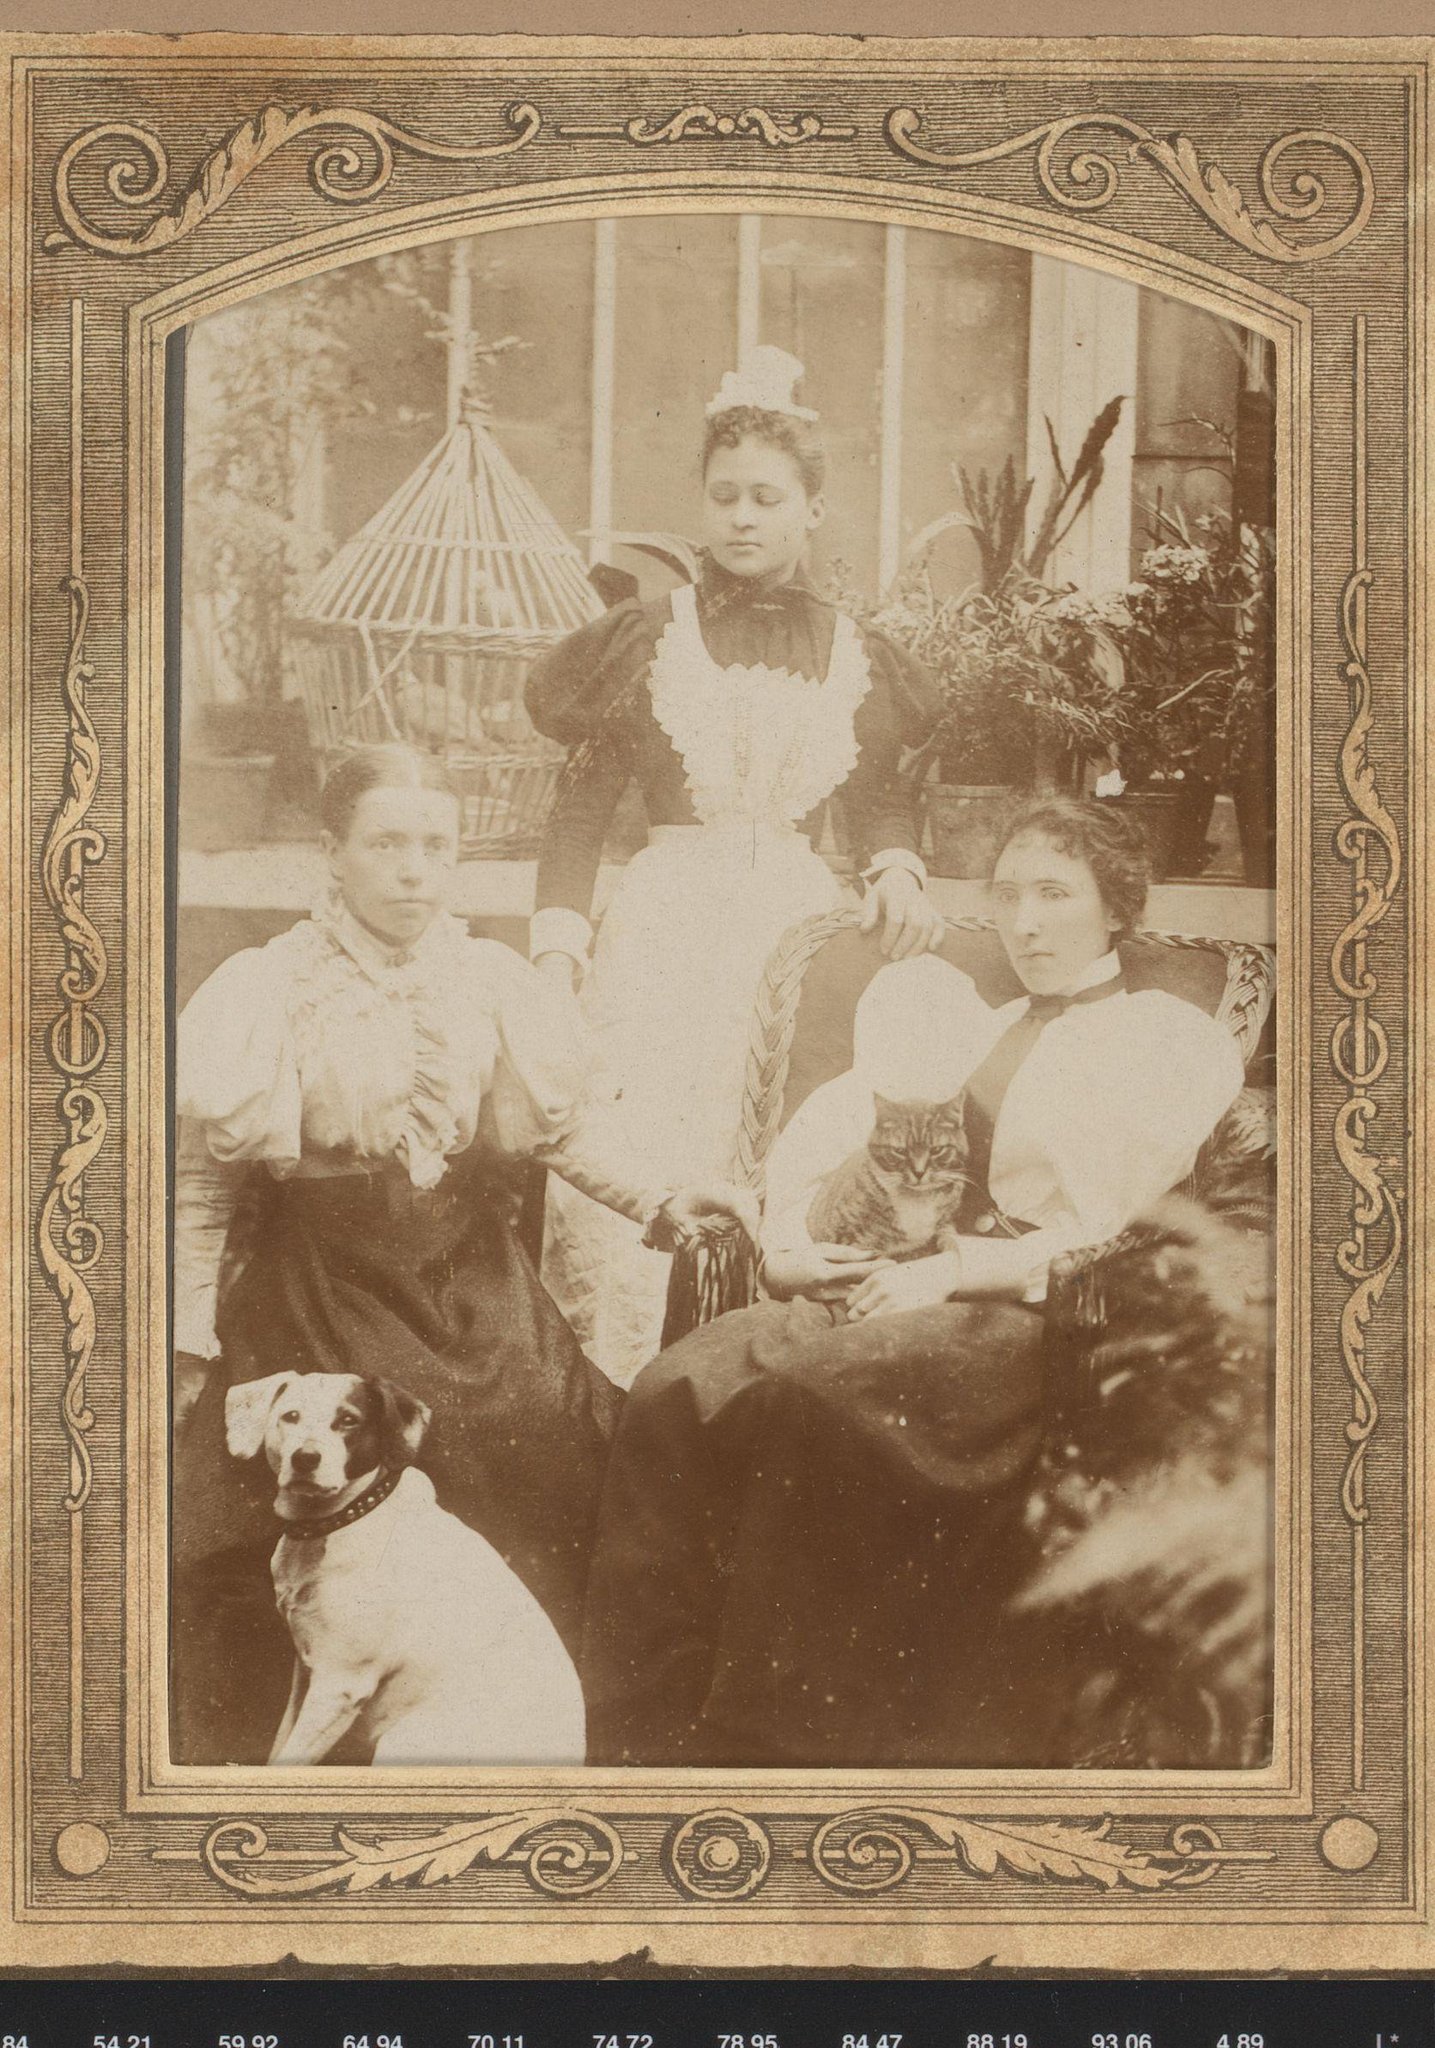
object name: photomechanical print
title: Portret van twee vrouwen en een bediende en een hond en kat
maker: Anonymous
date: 1860-1900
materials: cardboard, paper, photographic support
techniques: albumen print, planographic printing, printing block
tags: adult woman, cat, historical persons, house personnel, servants, dog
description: Op het albumblad, rondom het passe-partout, reproducties van prenten van onder meer een gezicht op Amsterdam en het wapen van Amsterdam. Deze foto maakt deel uit van een album.